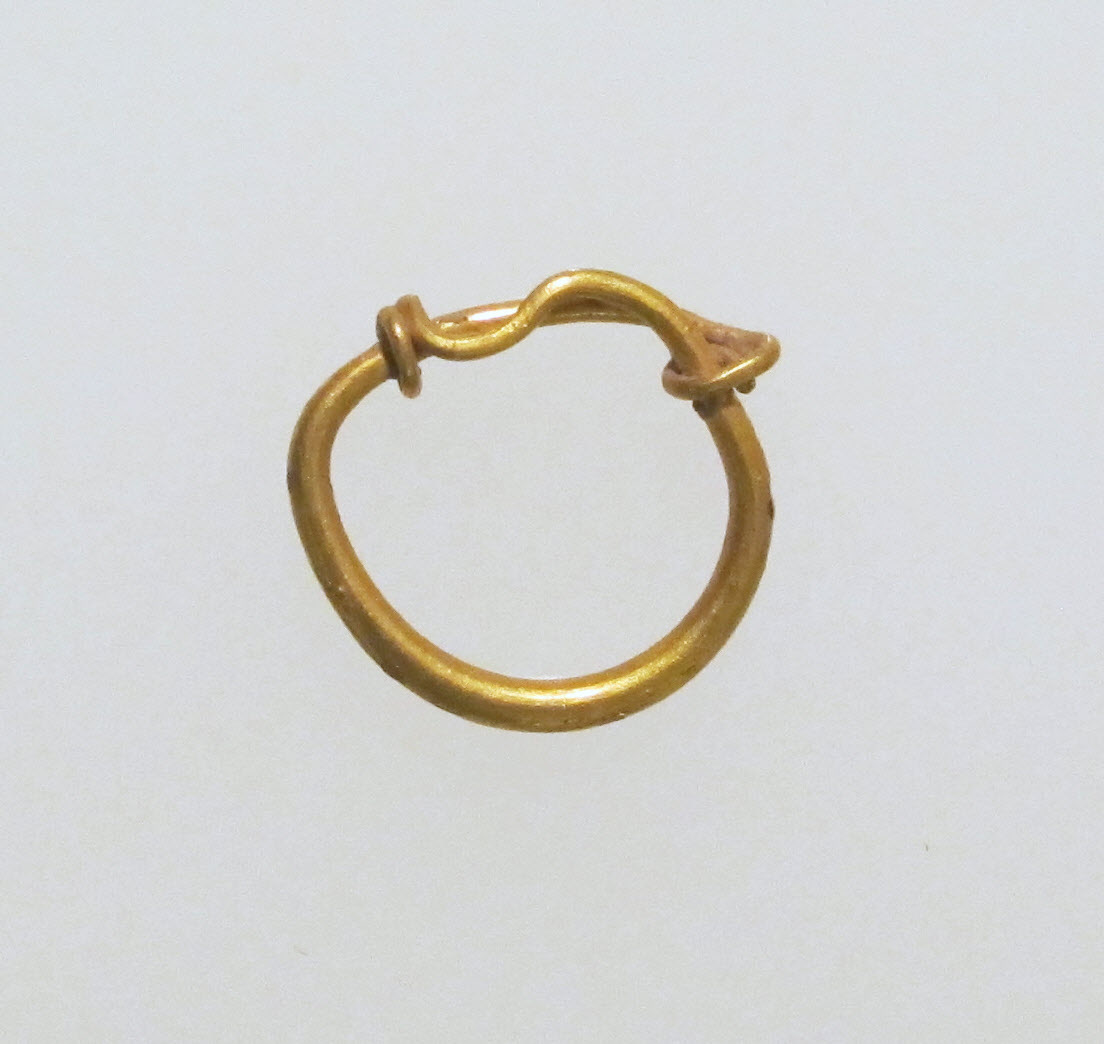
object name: earring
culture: etruscan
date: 900-100 BCE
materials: gold